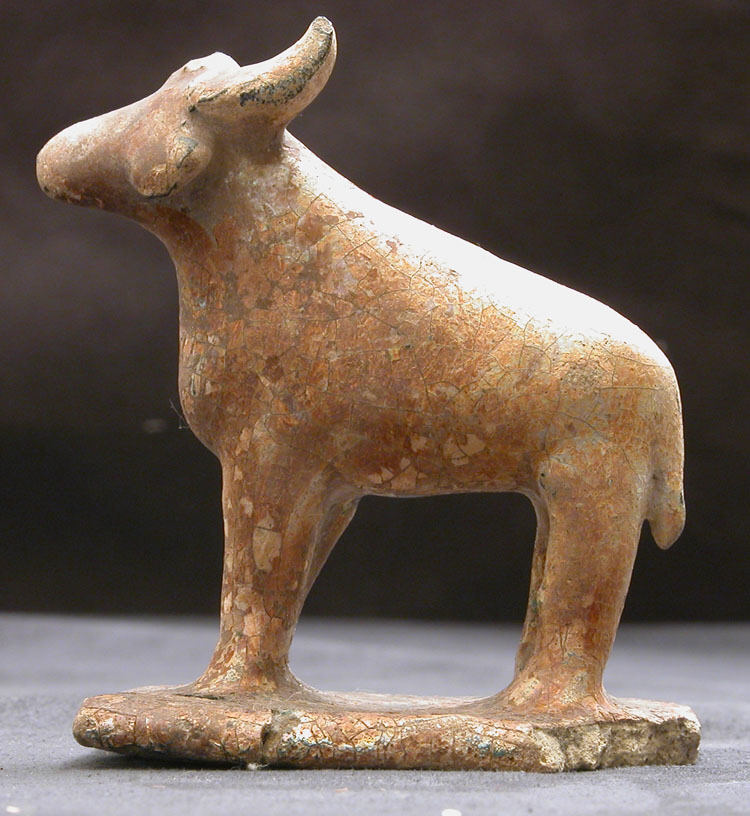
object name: figure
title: Figurine of a Bovine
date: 1101-1200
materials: glaze, stonepaste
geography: syria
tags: animals